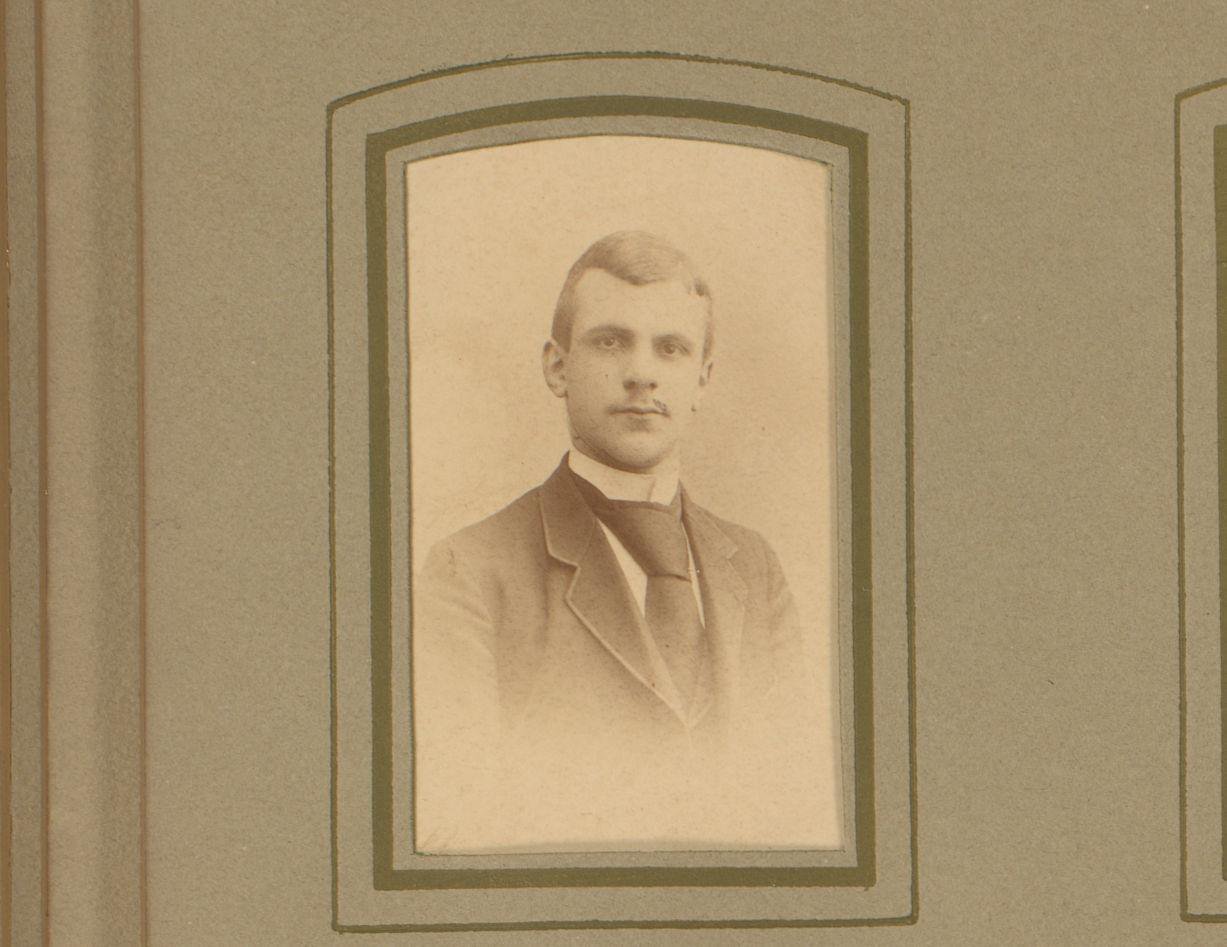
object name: album leaf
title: Portret van een man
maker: büttinghausen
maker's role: fotograaf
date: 1886-1906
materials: cardboard, photographic support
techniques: albumen print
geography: amsterdam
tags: historical persons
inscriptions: inscription: ‘Specialiteit in Vergrootingen/ KOOLDRUK/ Onveranderlijk/ M. Büttinghausen/ Amsterdam/ EENIG ATELIER/ Kalverstraat, hoek Spui/ De plaat blijft ter nabestelling bewaard.’